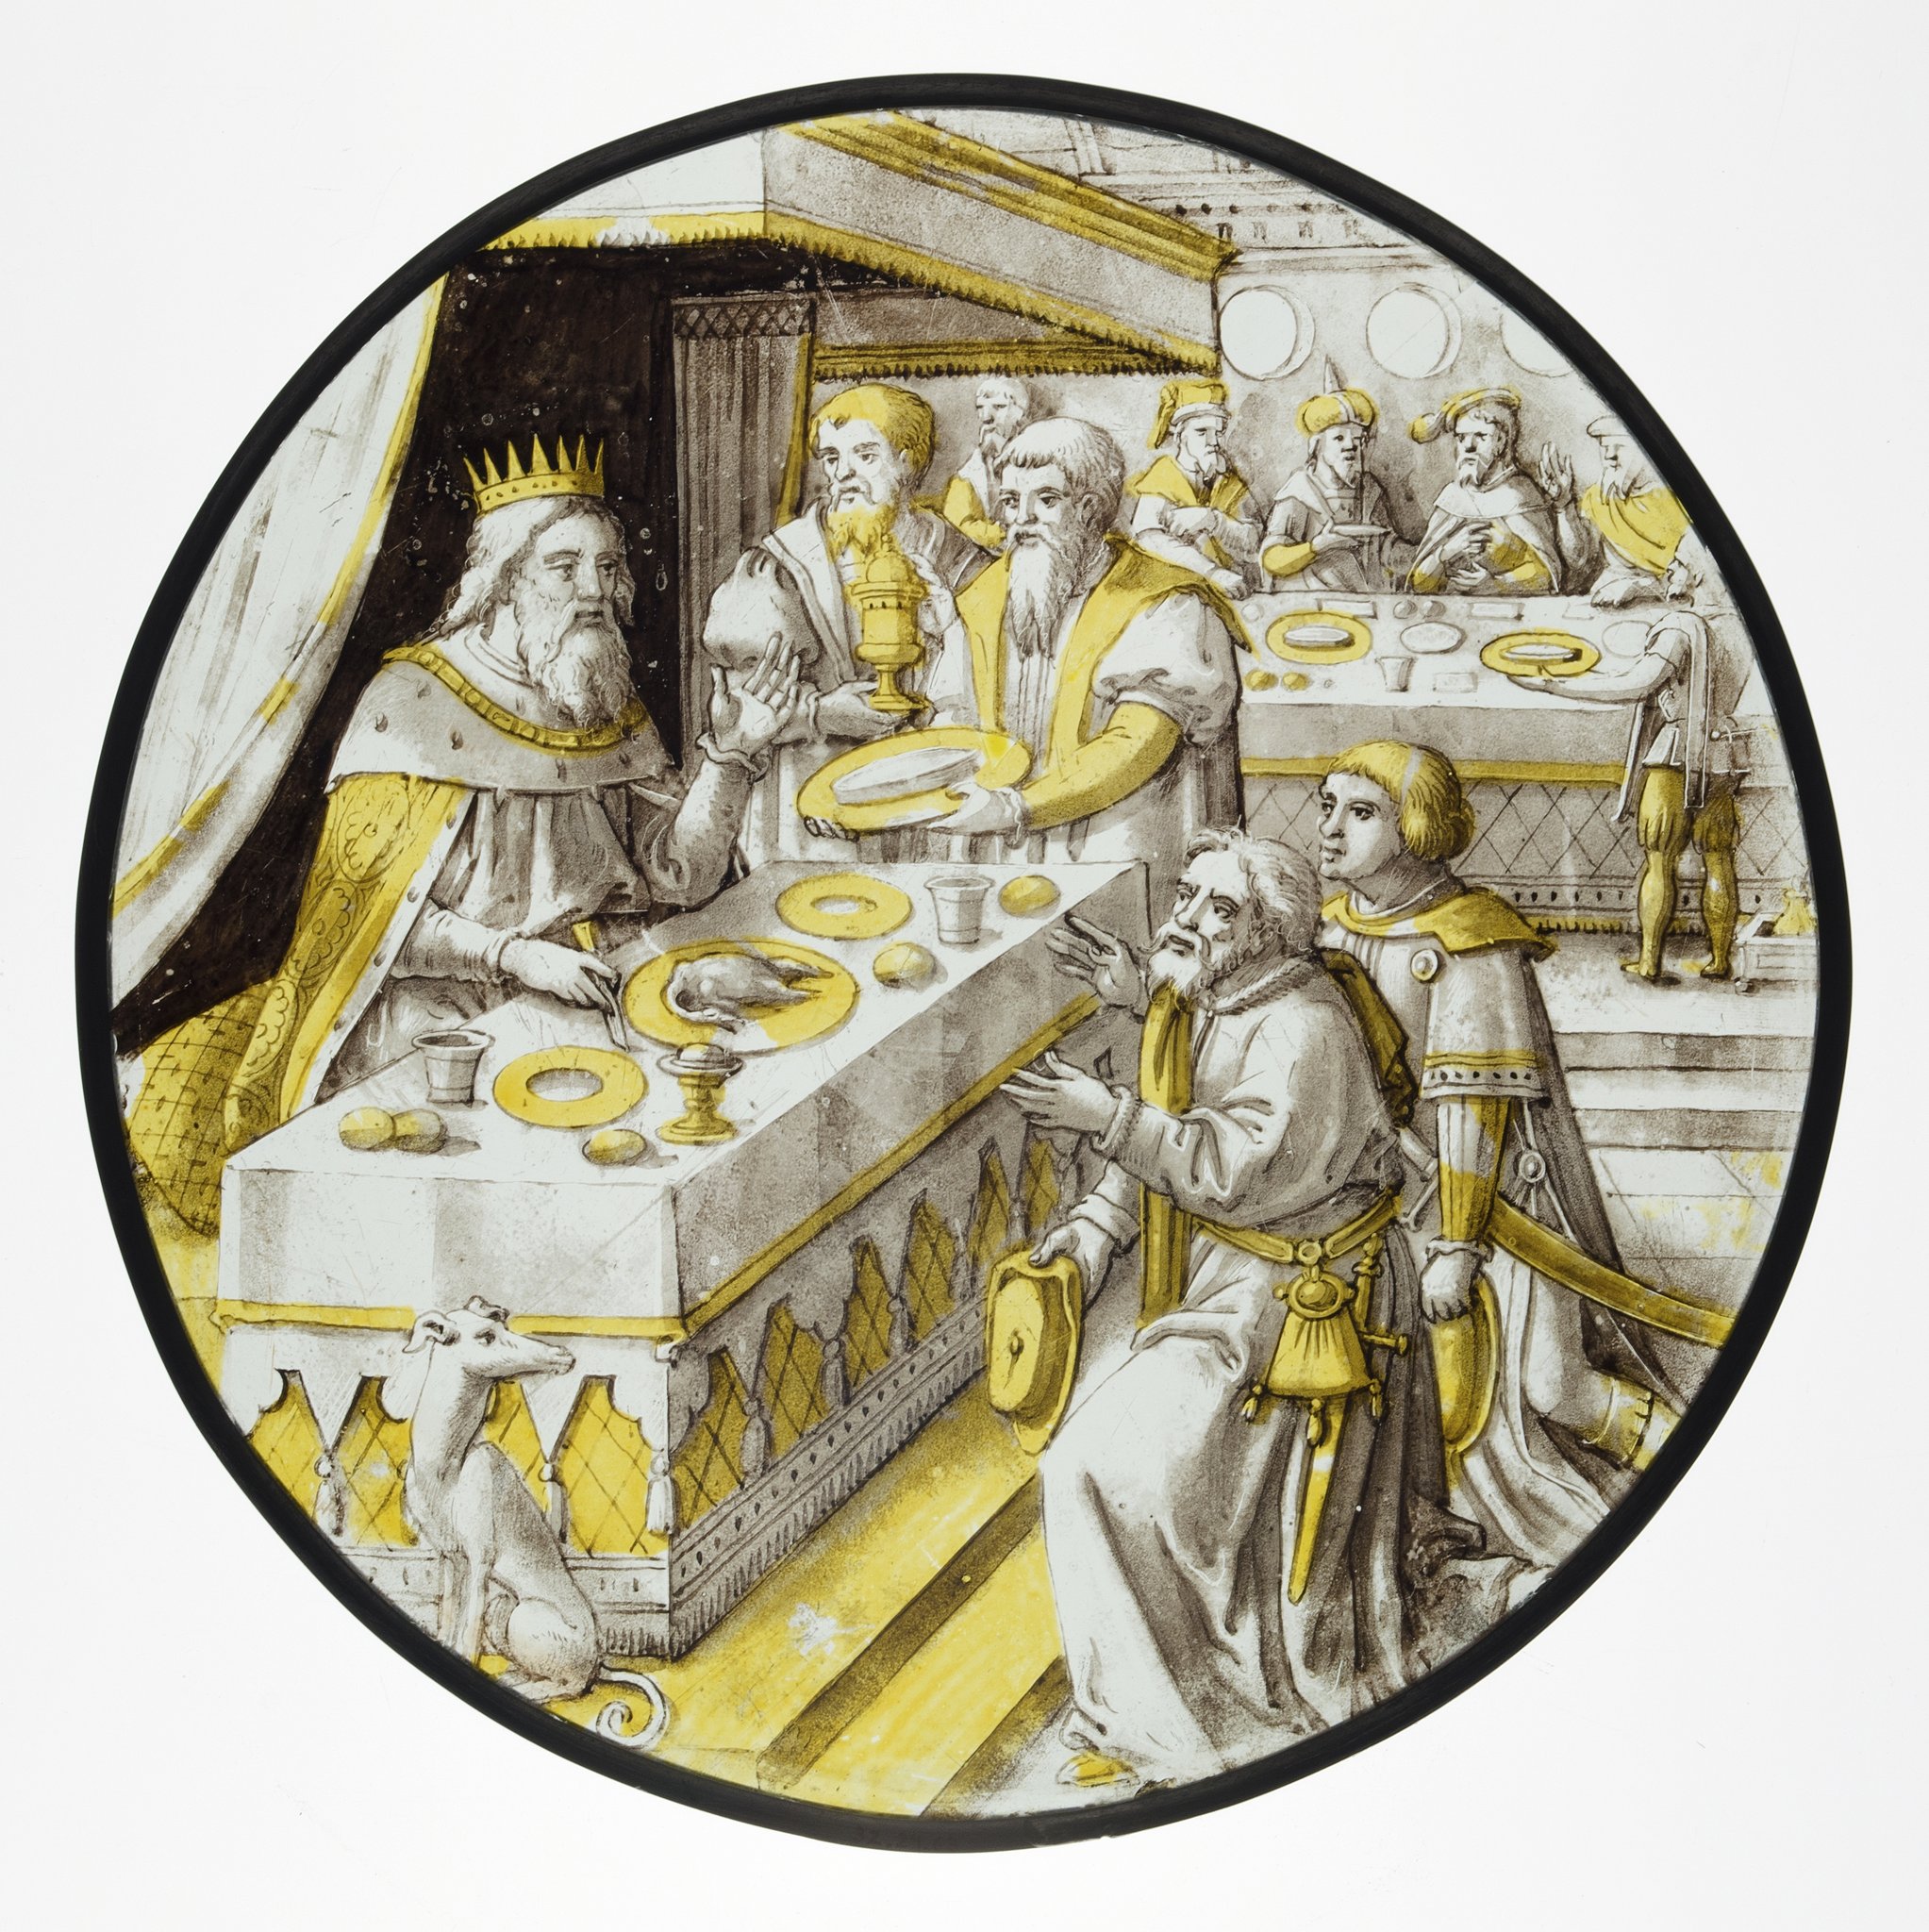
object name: roundel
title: Roundel with Joseph Presenting his father, Jacob, to the Pharoah (from a Series of the History of Joshua)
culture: south netherlandish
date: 1515-1530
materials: glass, paint, pigment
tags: men,dogs,joshua,dining